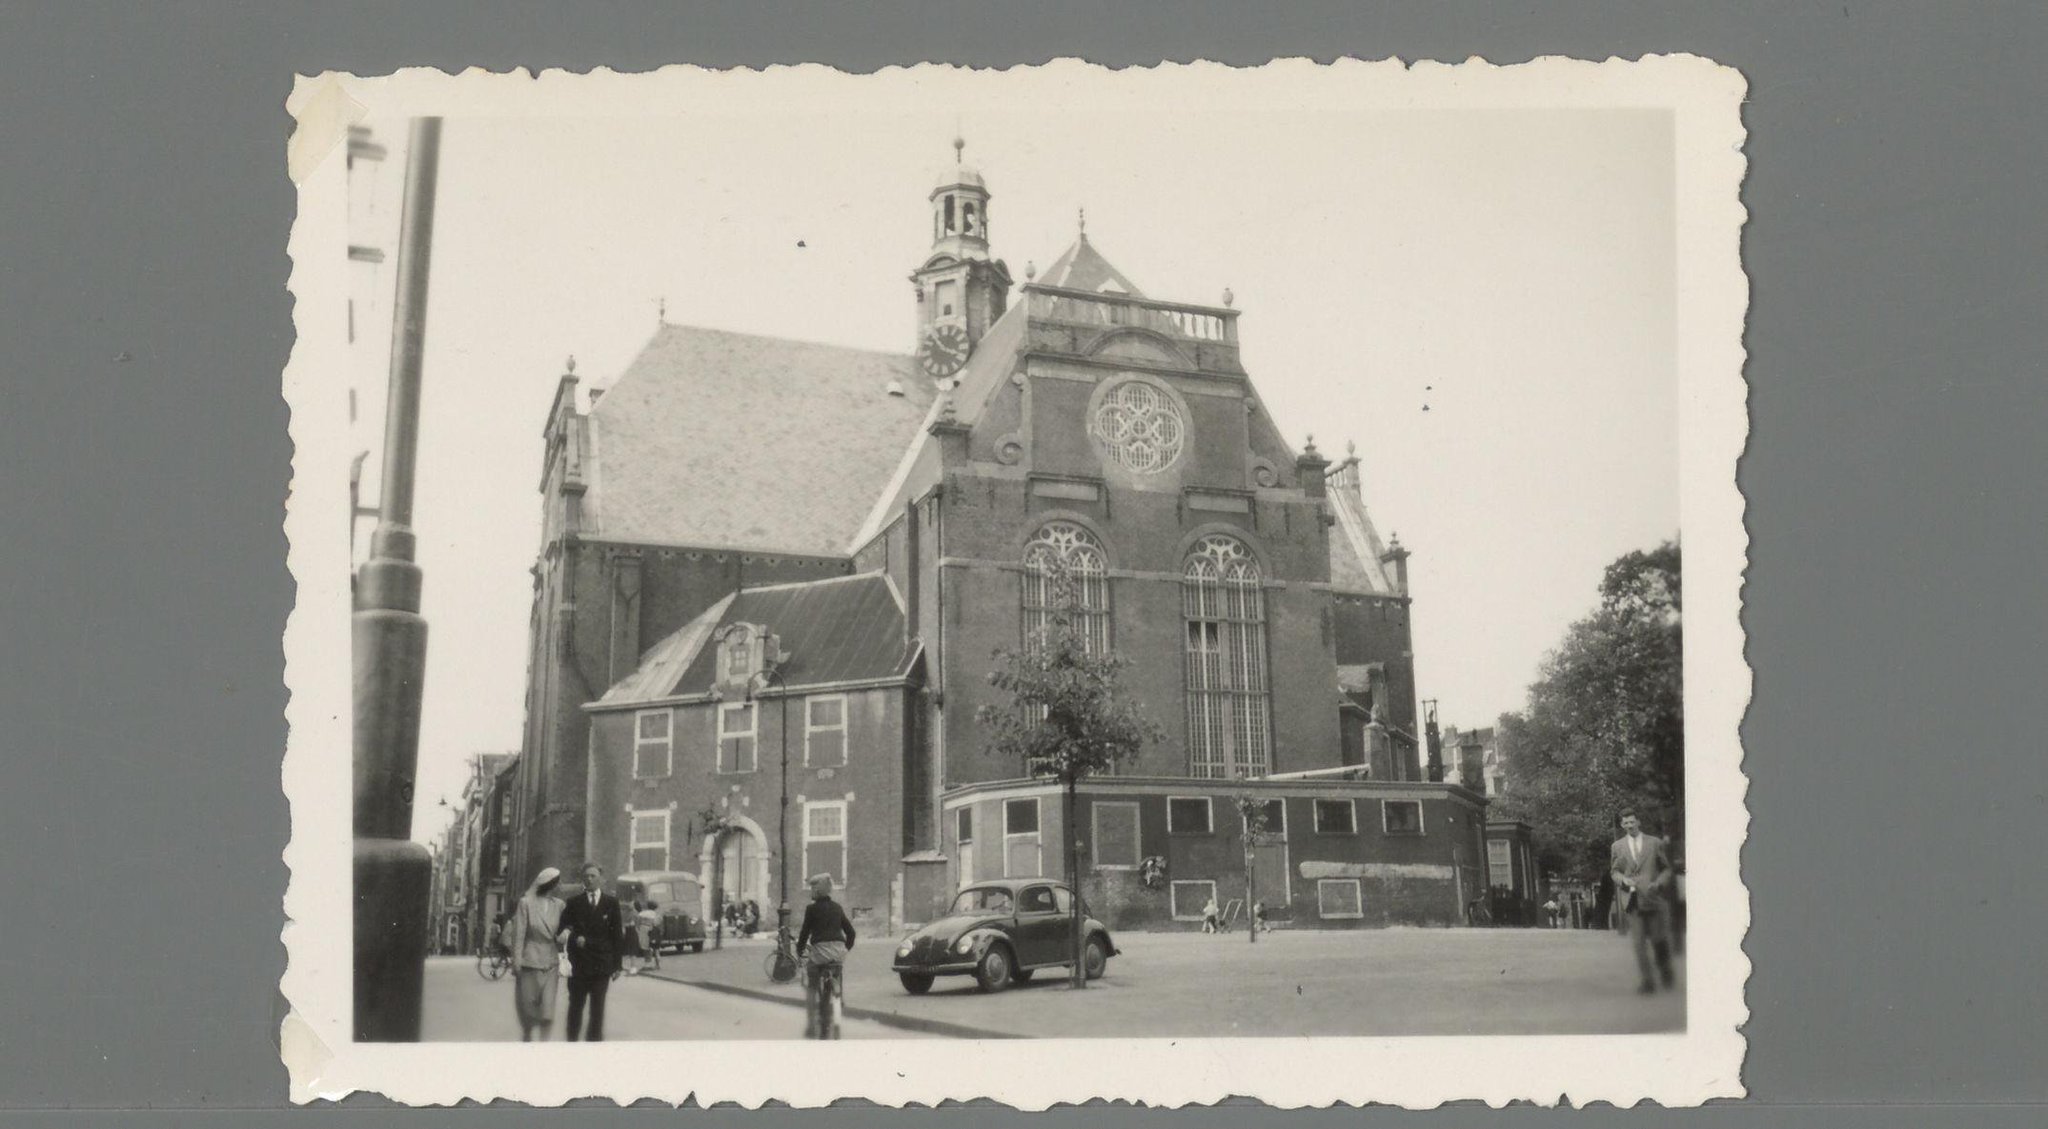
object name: photograph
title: Gezicht op de Zuiderkerk te Amsterdam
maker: Anonymous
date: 1954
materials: paper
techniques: gelatin silver print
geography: amsterdam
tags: church (exterior)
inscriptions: inscription: ‘Amsterdam Zuiderkerk 1954’, factory mark: ‘Velox’